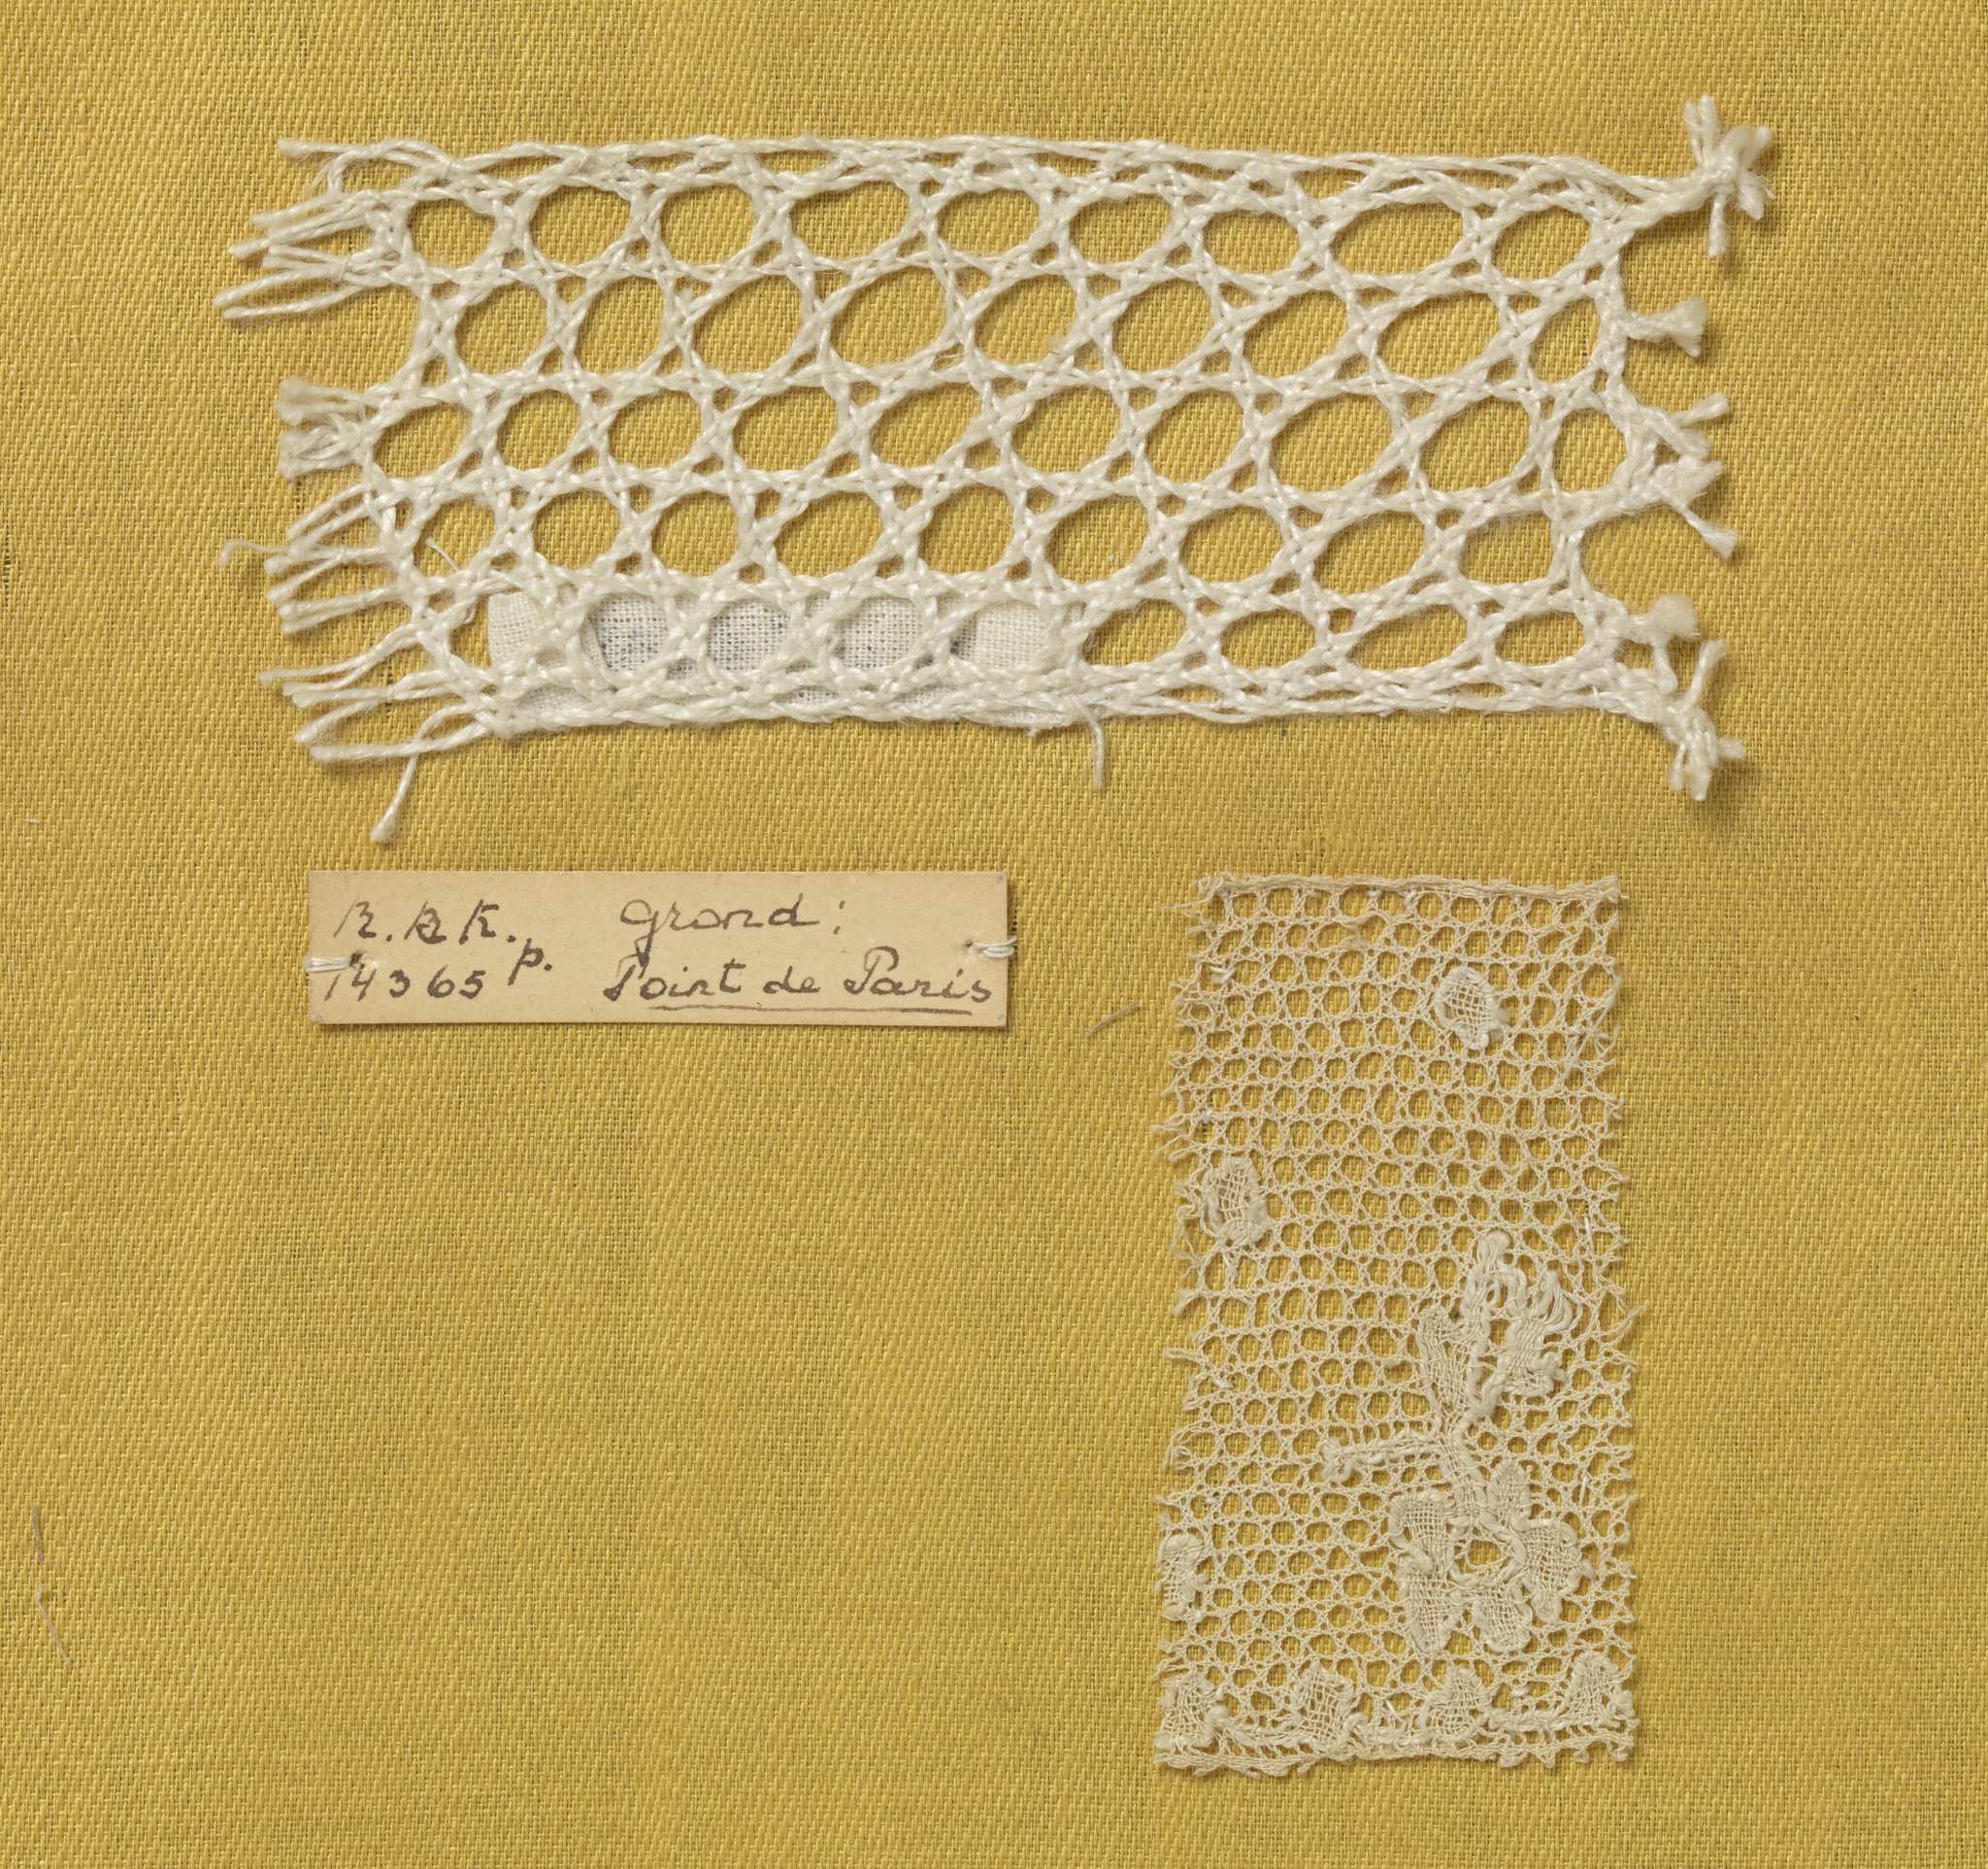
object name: sample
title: Staal kloskant met grove draad als voorbeeld van Parijse grond (traliegrond)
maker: Anonymous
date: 1900-1930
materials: cotton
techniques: lace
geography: amsterdam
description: Staal naturelkleurige kloskant met grove draad als voorbeeld van een Parijse grond met daarbij een fragment kant waarin deze techniek is toegepast. De datering betreft het staal.